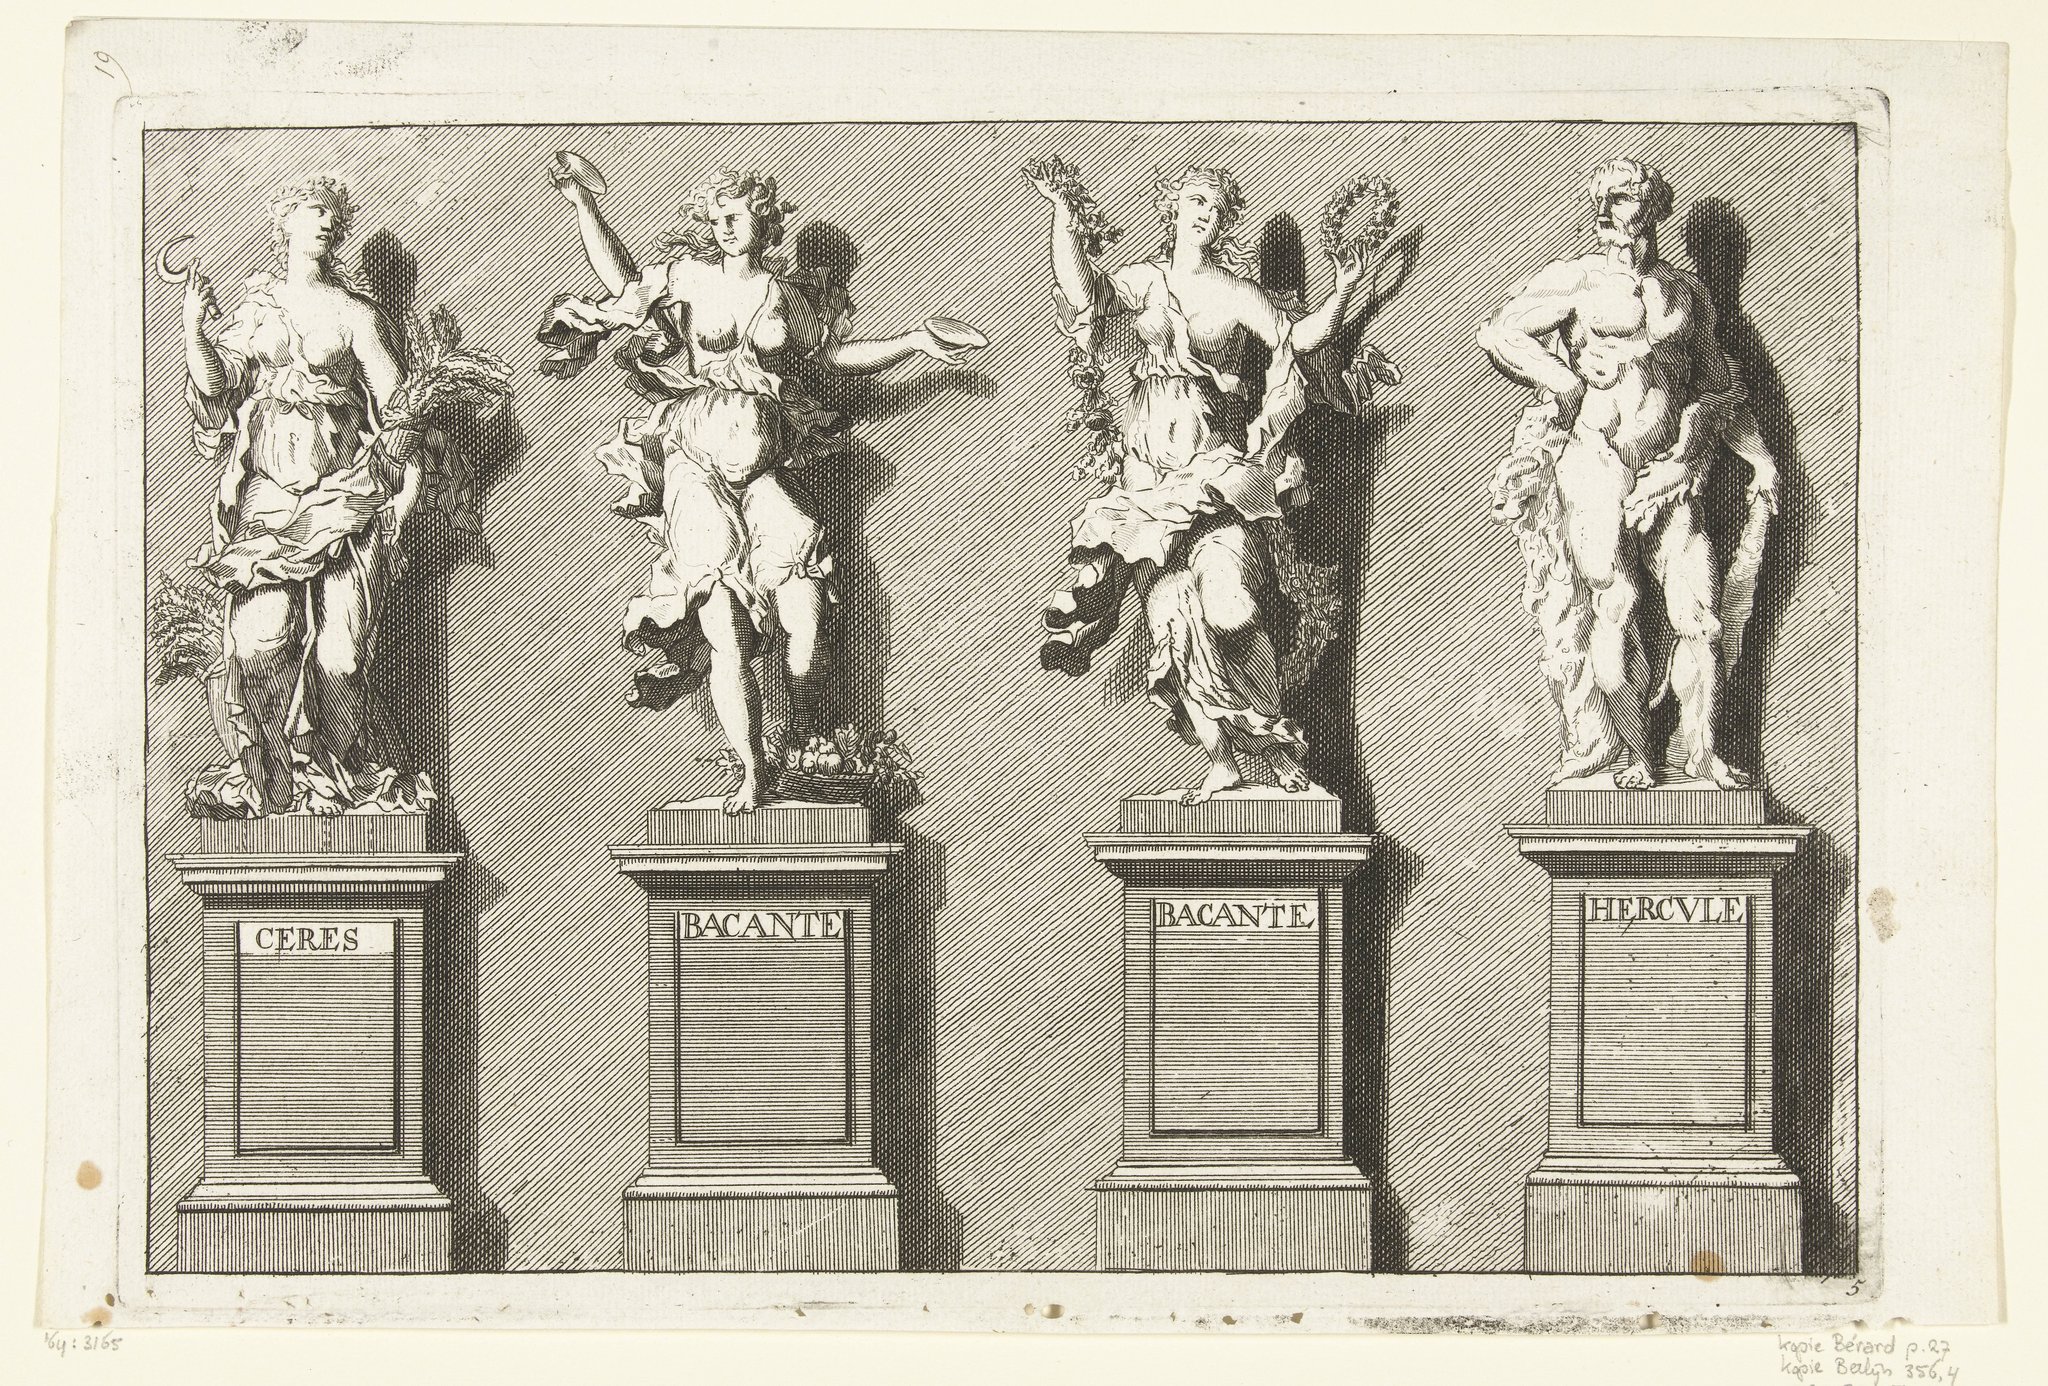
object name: ornament print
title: Vier beelden op een sokkel: Ceres, twee Bacchanten, Hercules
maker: Anonymous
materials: paper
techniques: etching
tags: (story of) ceres (demeter), (story of) hercules (heracles), male bacchant(es), piece of sculpture, reproduction of a piece of sculpture, statues, sculptures in garden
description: Vier beelden op voetstukken. Hun namen op de sokkels. Kopie naar blad uit serie Liure de Statues uitgegeven door Daniel Marot.